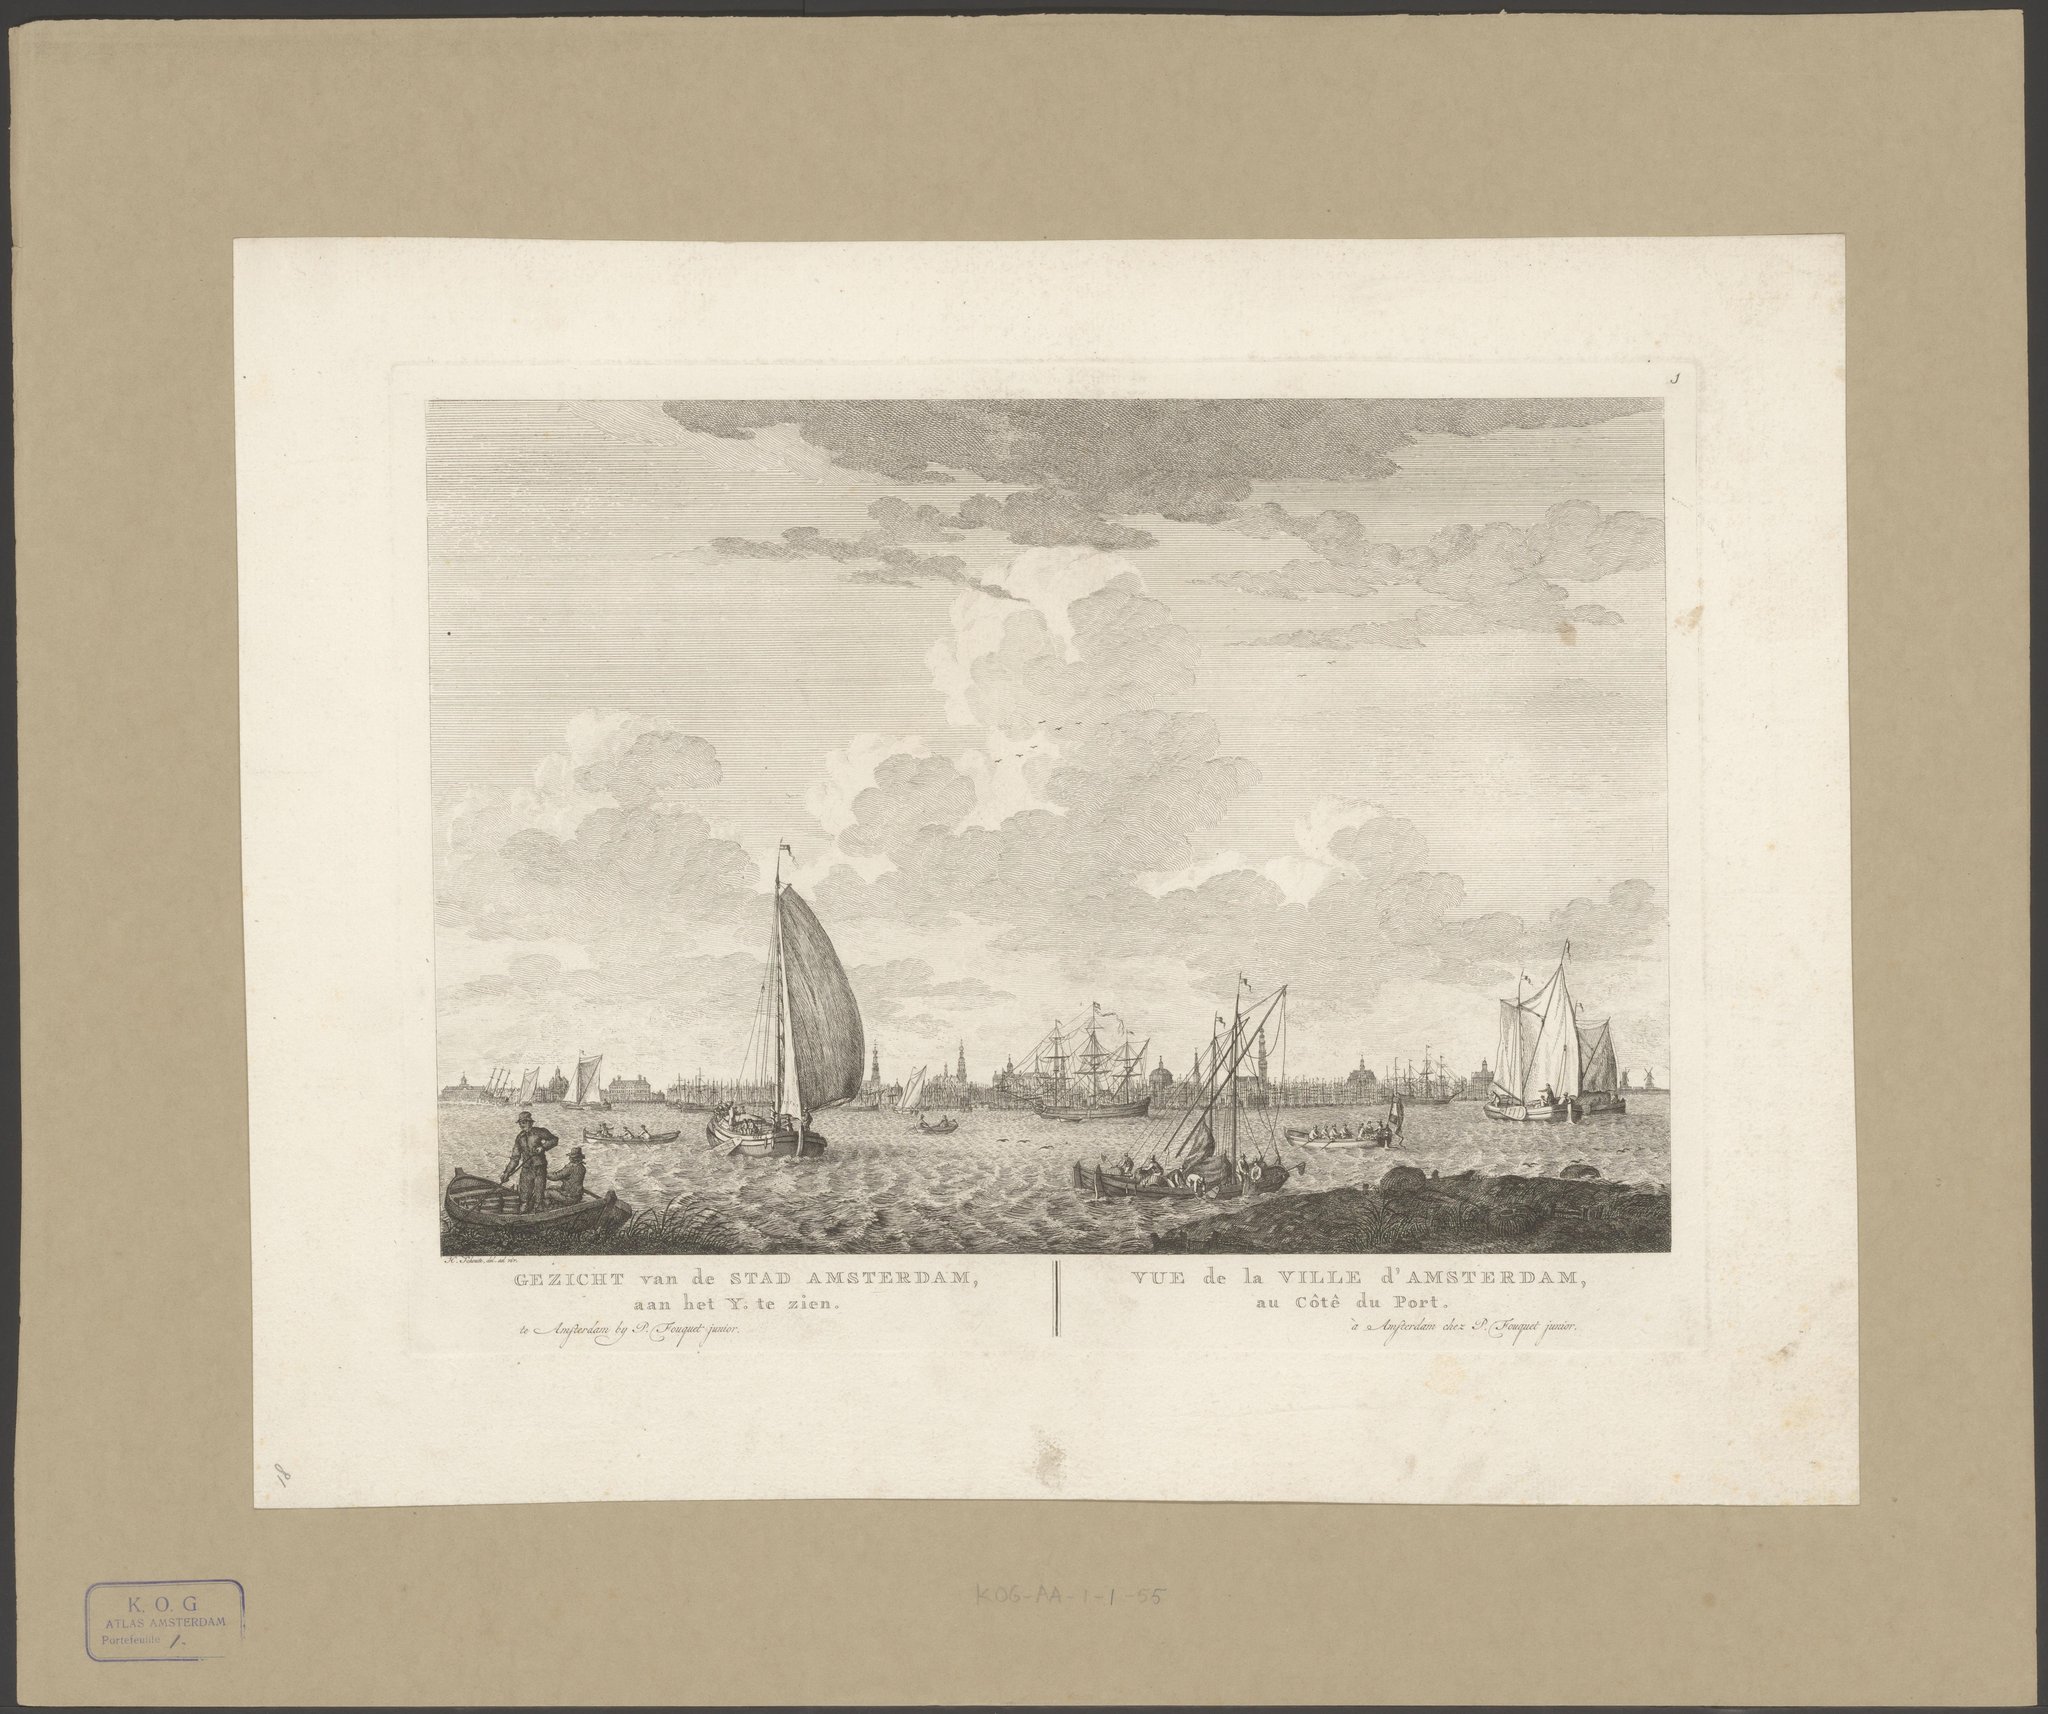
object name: print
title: Gezicht van de stad Amsterdam, aan het Y. te zien / Vue de la Ville d'Amsterdam, au Côtê du Port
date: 1783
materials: paper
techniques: engraving, etching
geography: amsterdam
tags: city-view in general; 'veduta', river, ships (in general) - cc - more than one ship, amsterdam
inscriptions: collector's mark: ‘1’ Lugt 1641b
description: Prent waarschijnlijk uit: Nieuwe atlas, van de voornaamste gebouwen en gezigten der stad Amsterdam, met derzelver beknopte beschryvingen. 2 dln. Amsterdam: Daniël Jean Changuion en Petrus den Hengst [in opdracht van Pierre Fouquet], 1783, dl. 1.